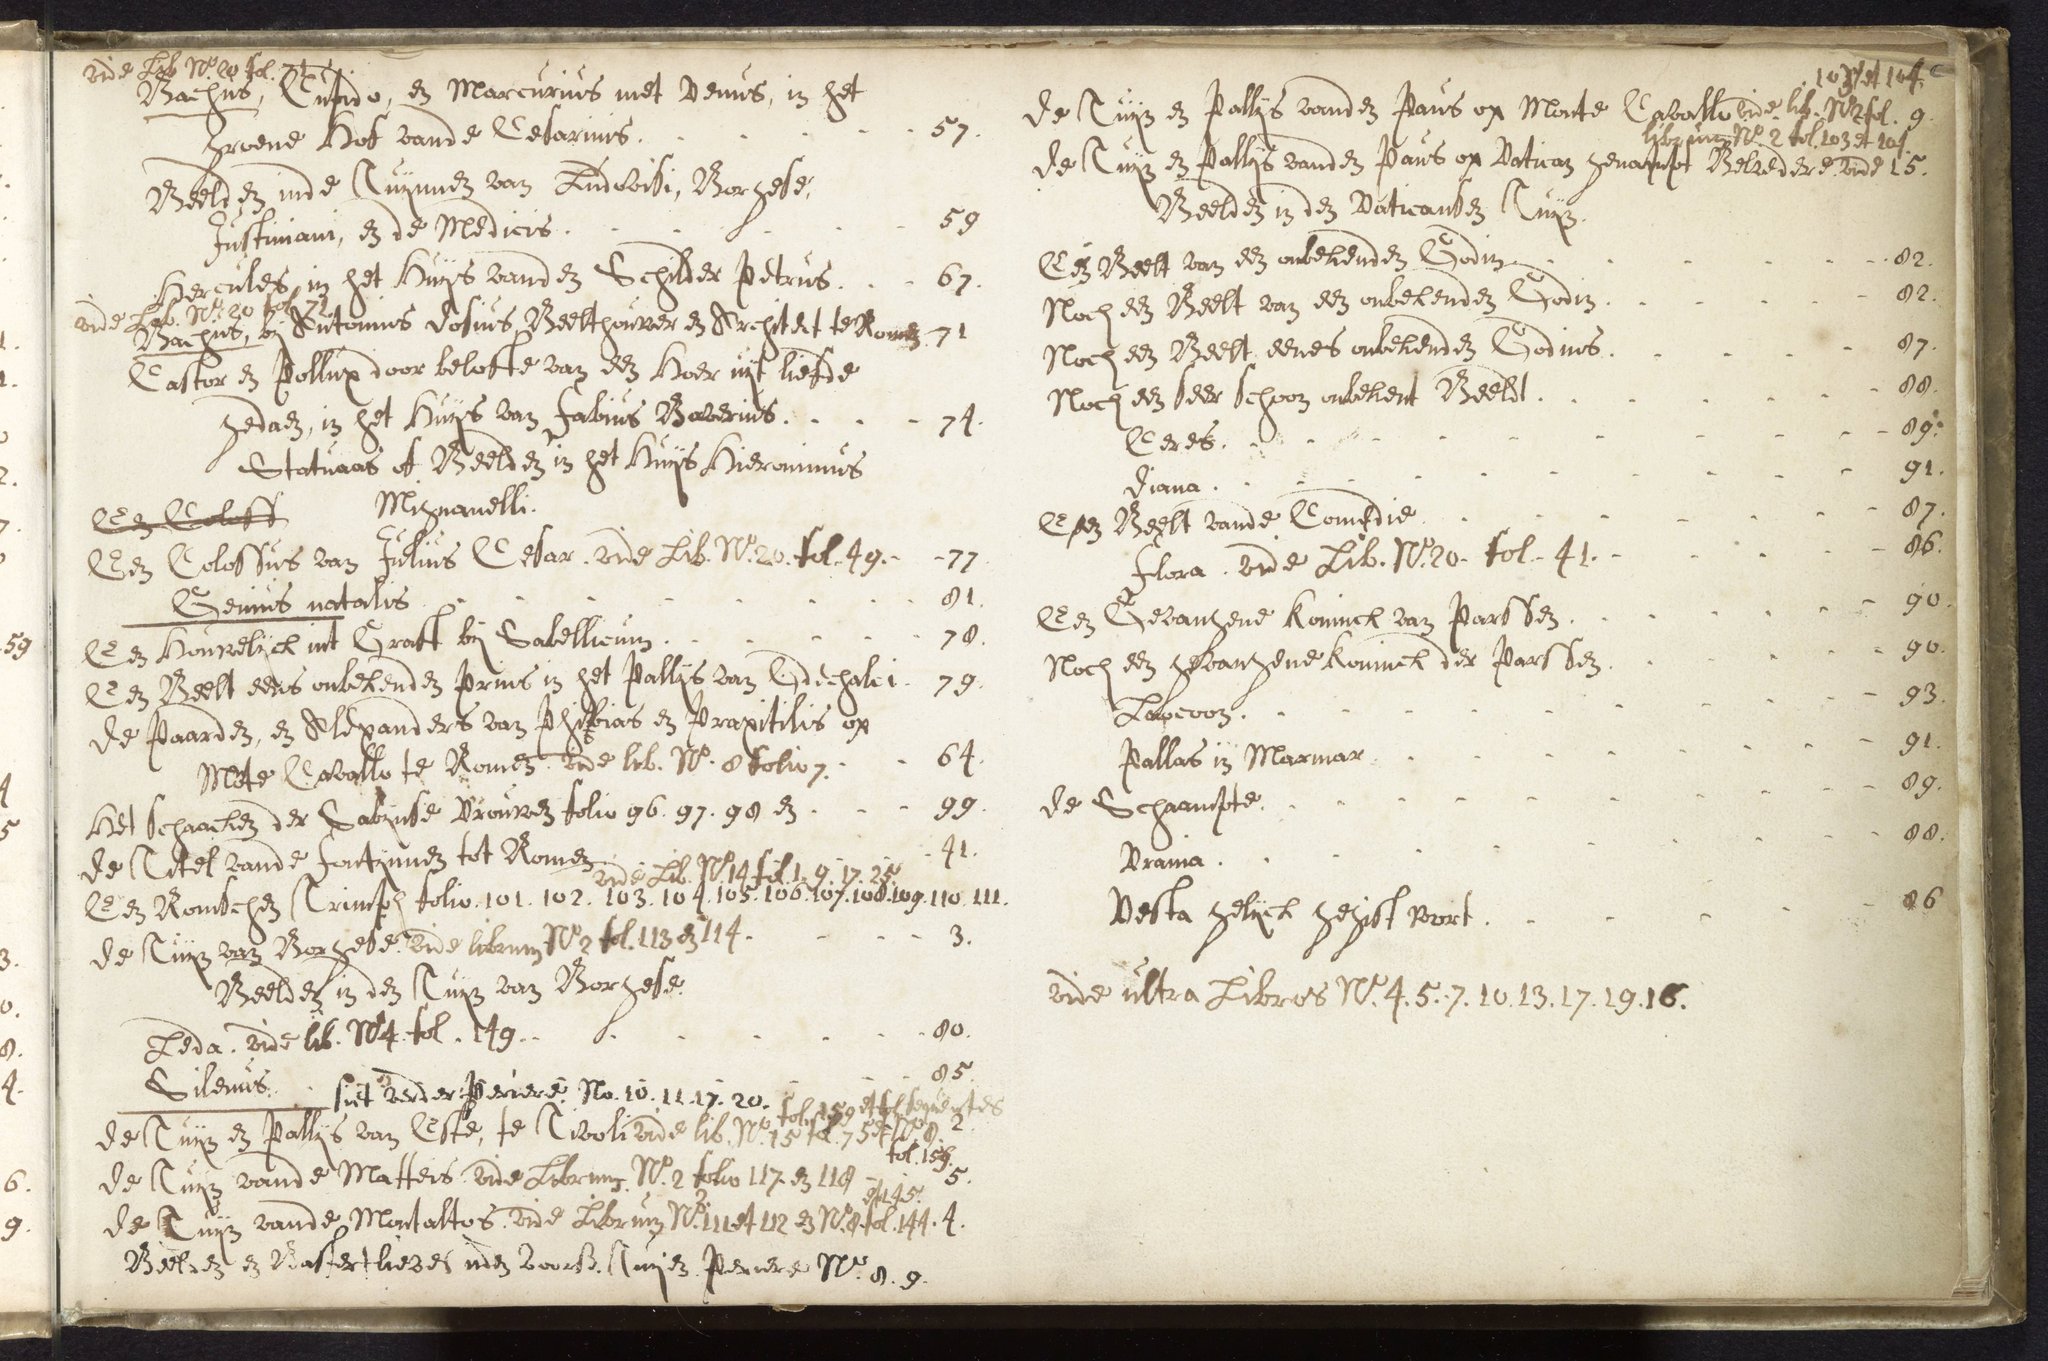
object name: album leaf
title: Handgeschreven inventaris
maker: michiel hinloopen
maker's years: 1619-1708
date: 1637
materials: paper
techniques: pen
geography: amsterdam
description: Inventaris maakt deel uit van een album.